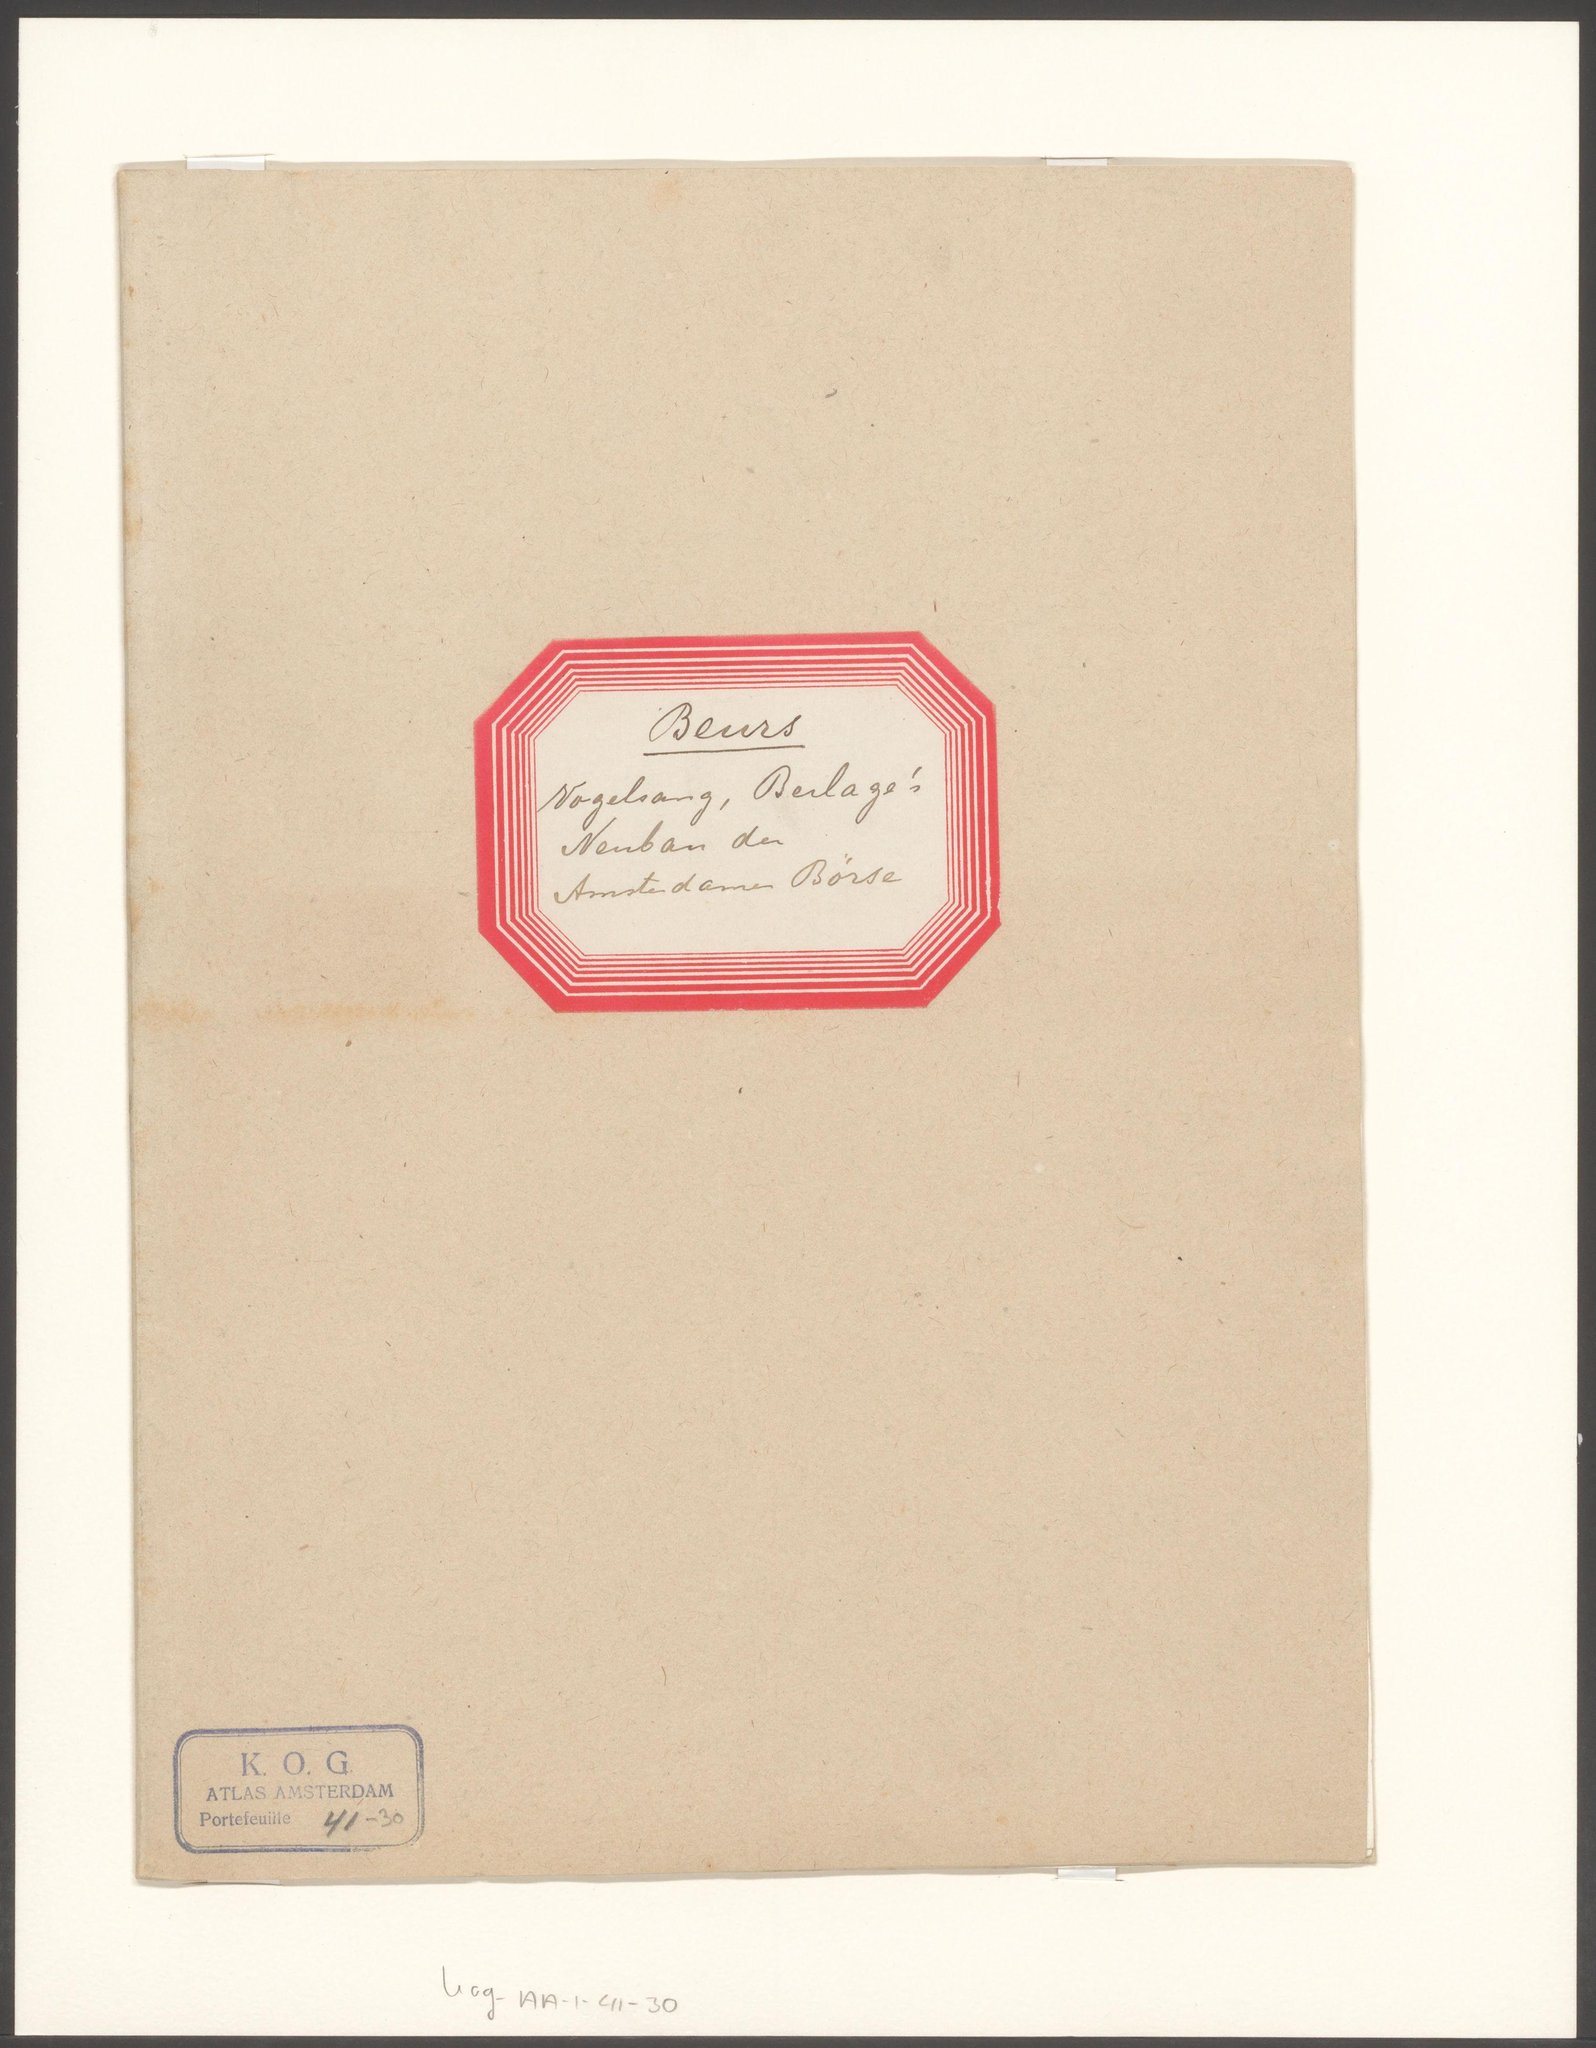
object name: article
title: H.P. Berlage's neubau der Amsterdamer Börse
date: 1903-1908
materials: paper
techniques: letterpress printing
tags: print maker, wilhelmina of the netherlands, stock exchange, stock-market, amsterdam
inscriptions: collector's mark: Lugt 1461b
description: Het artikel H.P. Berlage's neubau der Amsterdamer Börse door Willem Vogelsang. Het artikel bestaat uit 21 pagina's. In het artikel staan diverse afbeeldingen van de decoraties in de Beurs van Berlage. Pagina's zijn onderaan genummerd van 401 tot en met 422. Onderwerpsrubriek binnen de Atlas Amsterdam: B. Beurs op het Damrak.